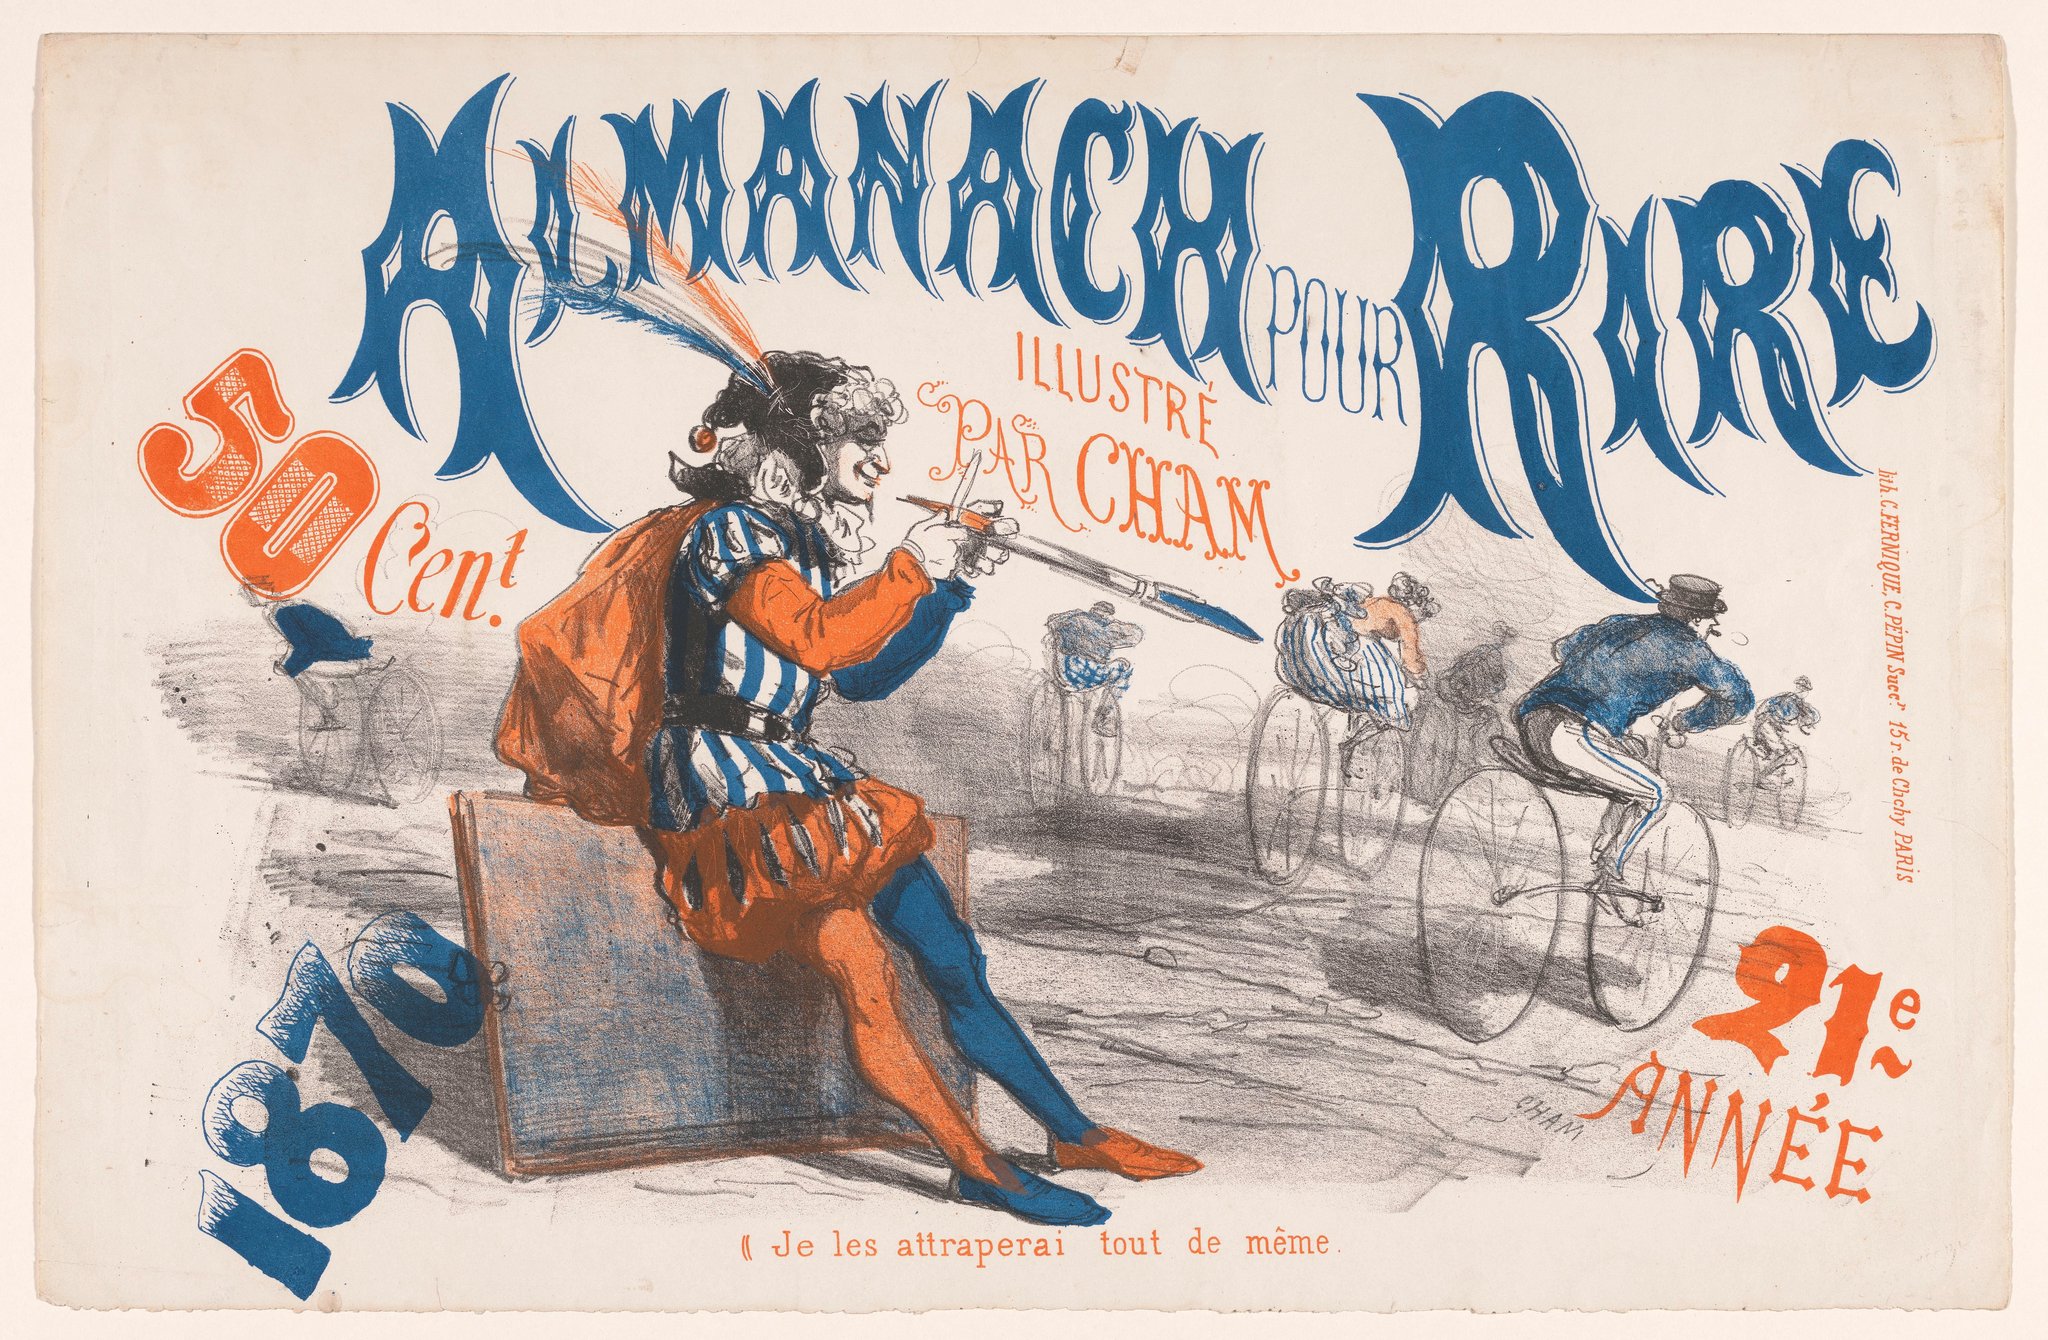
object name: reclamebiljet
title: Reclamebiljet voor de Almanach pour Rire voor het jaar 1870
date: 1870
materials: paper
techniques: lithograph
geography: paris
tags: buffoon (in general) (german: 'schalksnarr'), antique types of bicycles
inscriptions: collector's mark: Lugt 2228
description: Op een prentenmap zit een nar. Met een mes scherpt hij het uiteinde van een stuk lithografisch krijt. In de achtergrond zes fietsers.